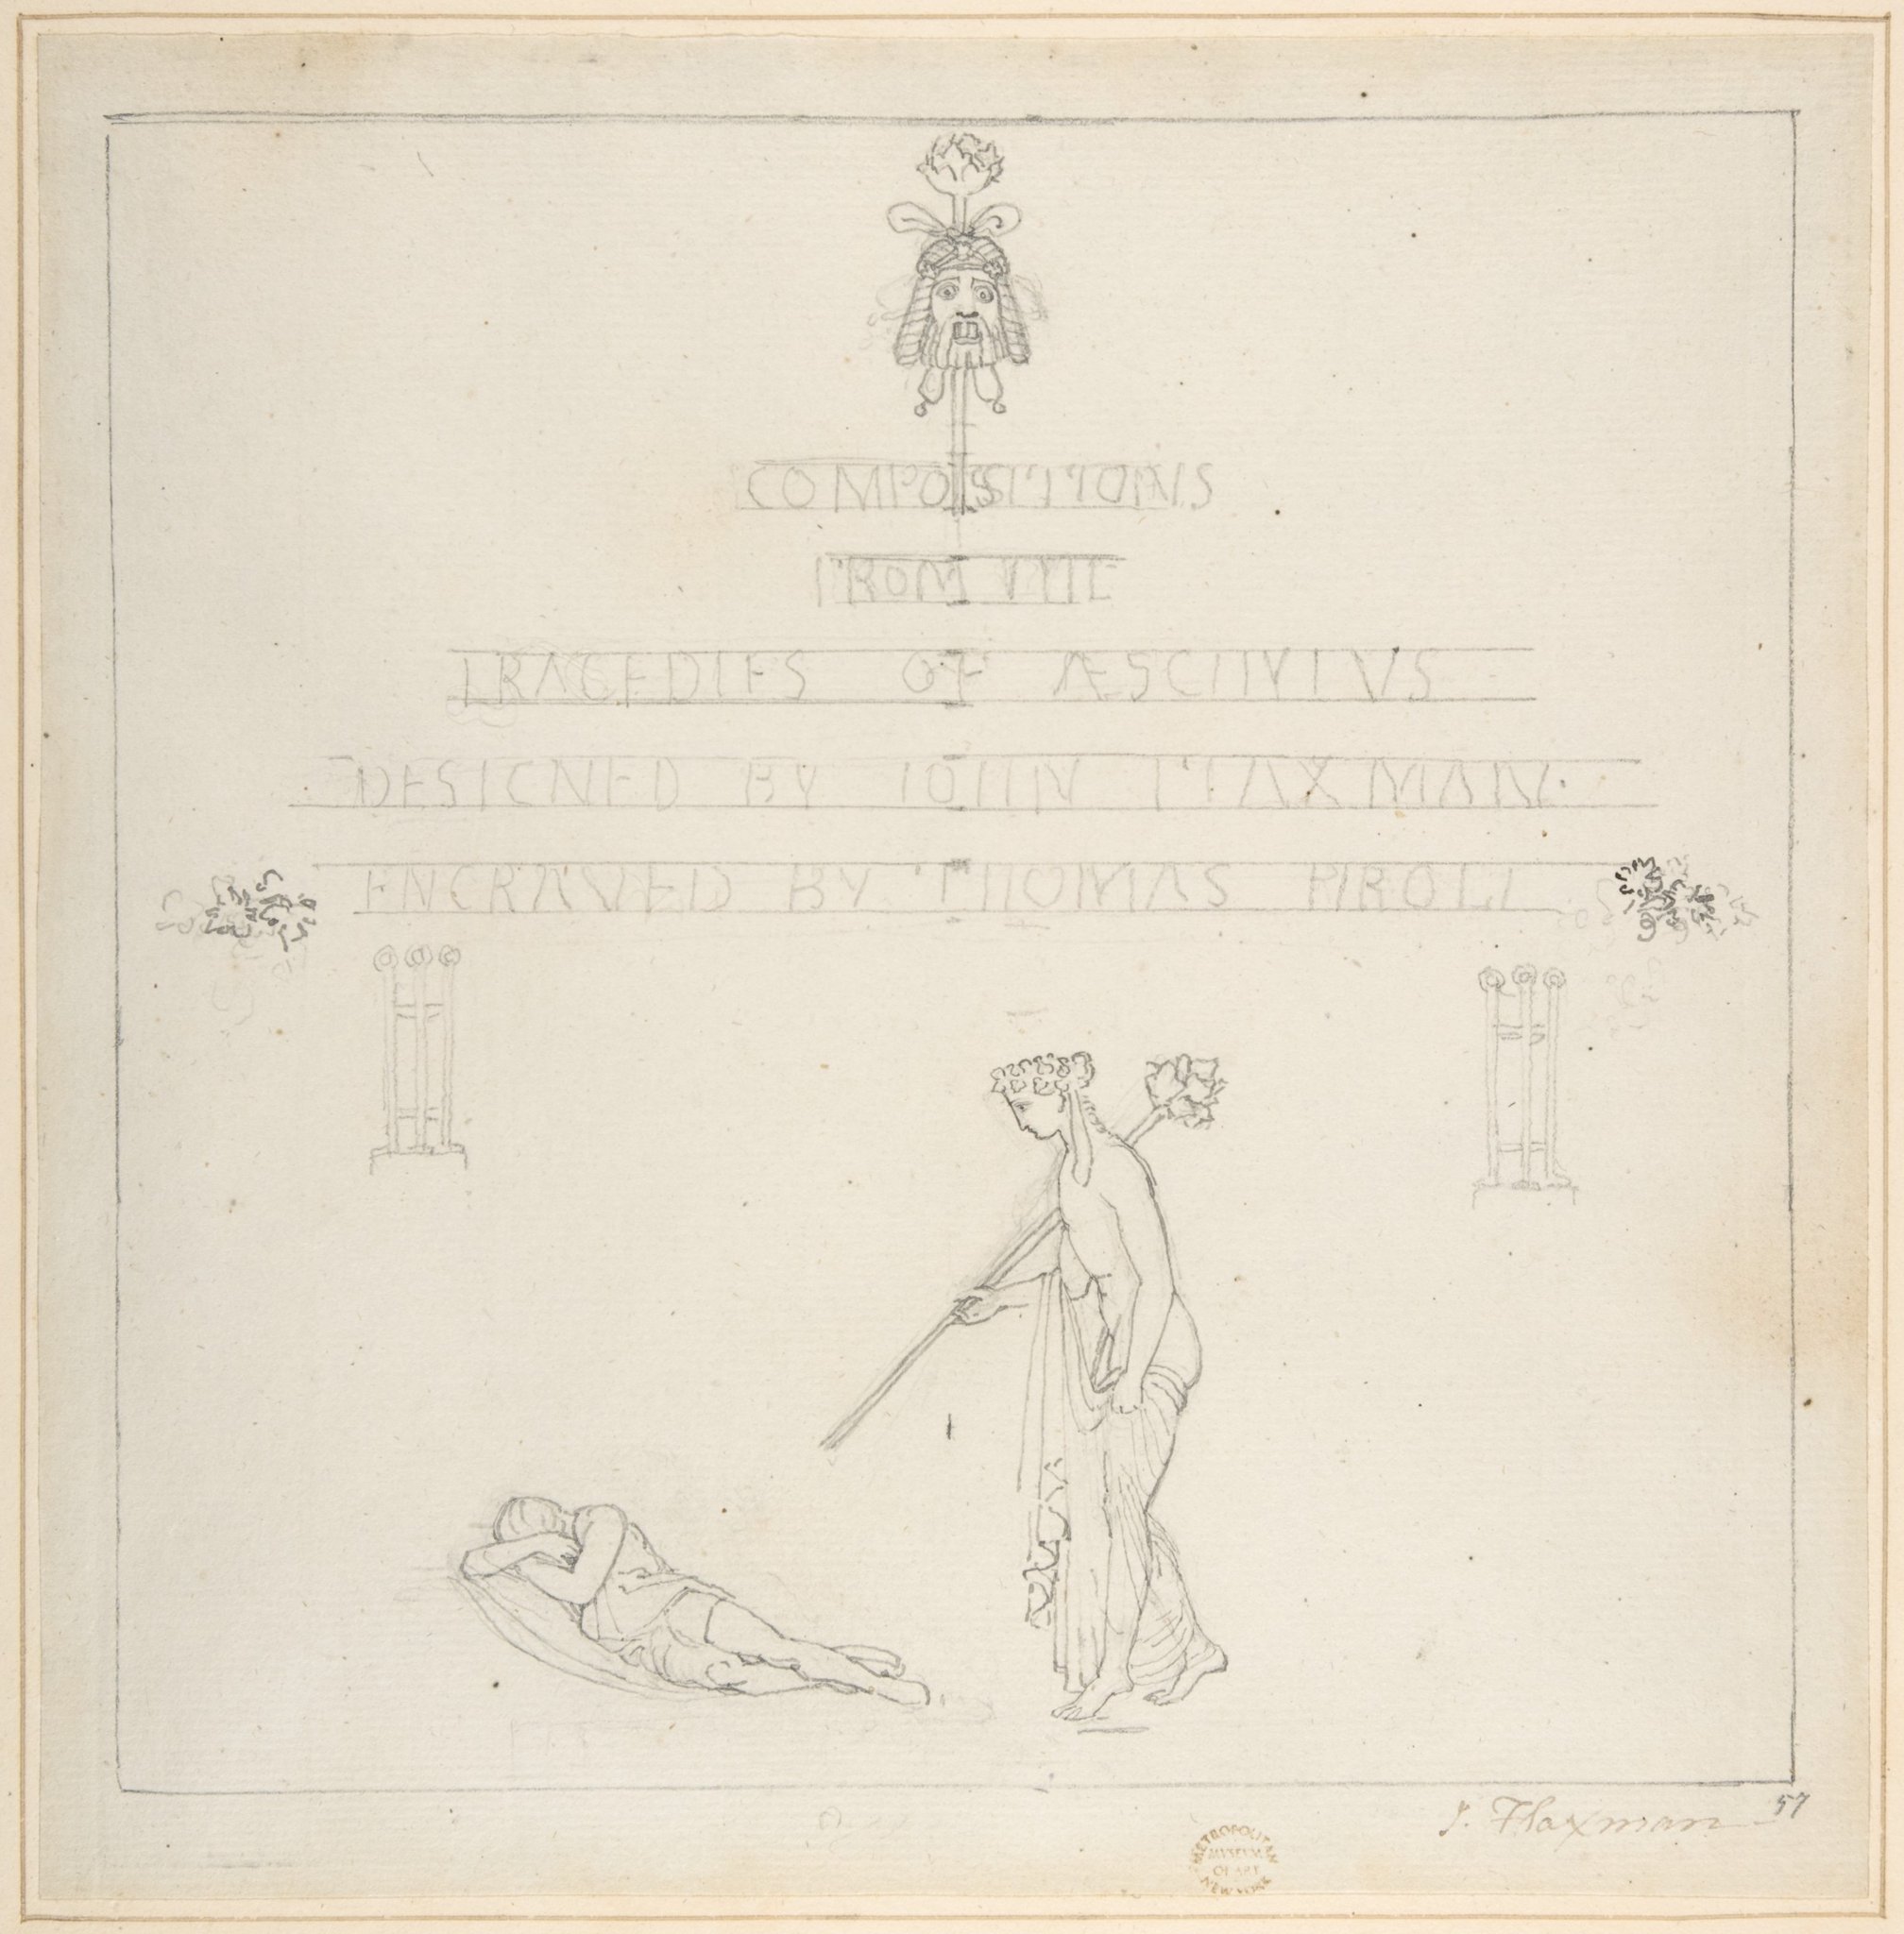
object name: drawing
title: Sketch for the Title-Page of an Edition of Aeschylus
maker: john flaxman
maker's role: artist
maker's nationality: british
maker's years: 1755-1826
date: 1793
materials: graphite, ink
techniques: pen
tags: faces,men